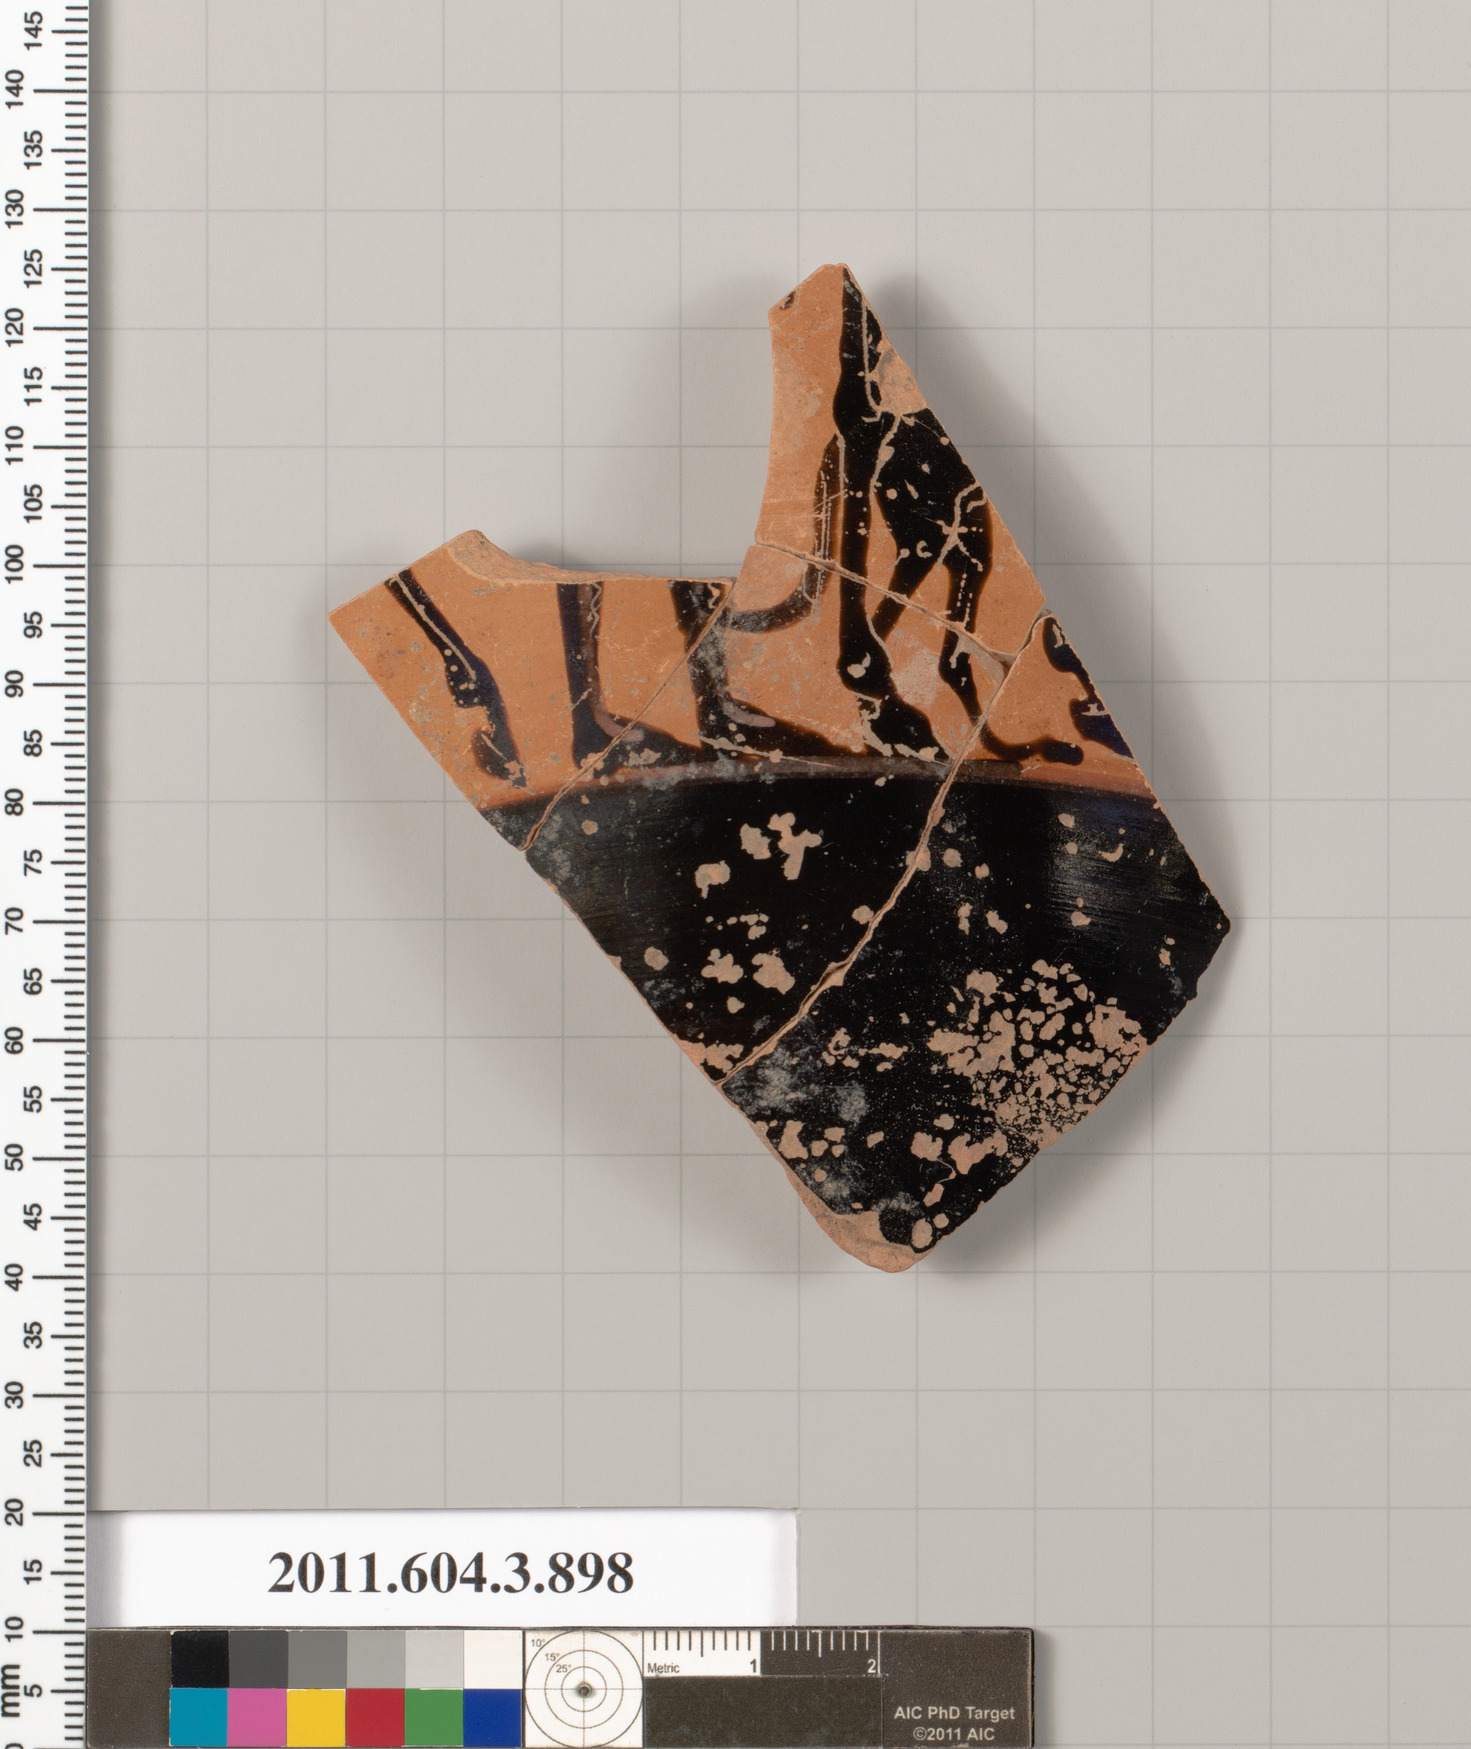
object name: lekythos fragment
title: Terracotta fragment of a lekythos (oil flask)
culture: greek, attic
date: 534-468 BCE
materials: terracotta